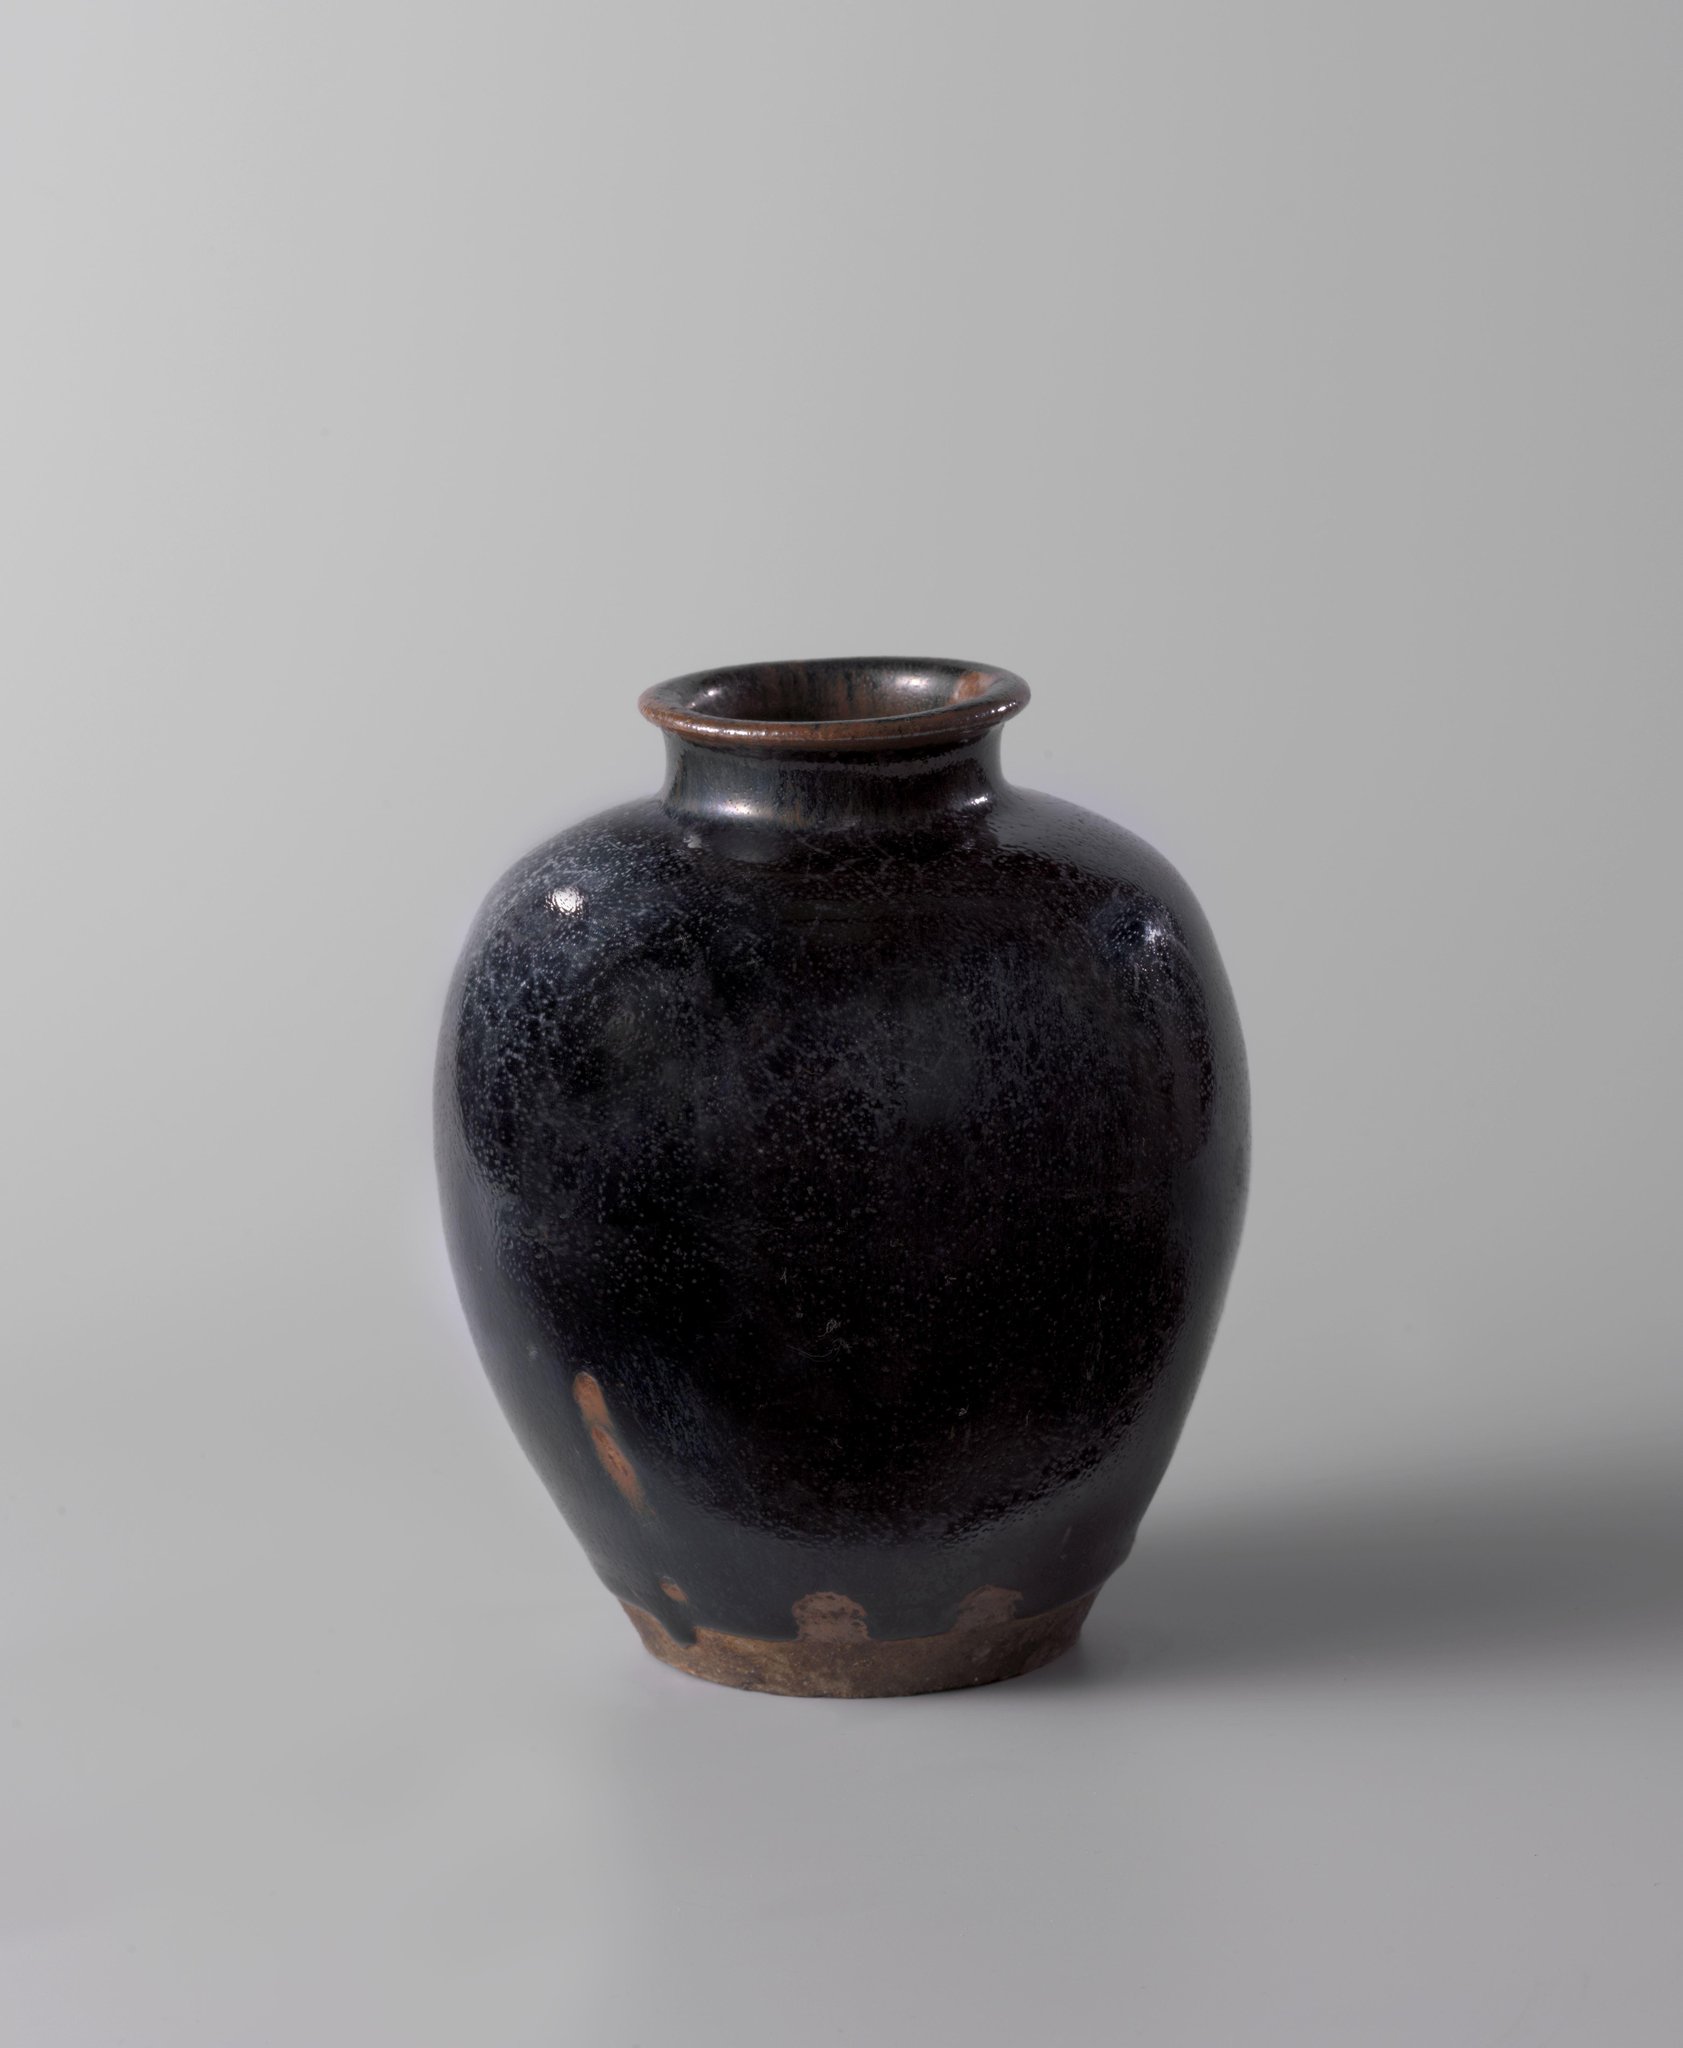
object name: vase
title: Ovoid vase with a black glaze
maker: Anonymous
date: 1000-1199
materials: glaze, stoneware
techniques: firing, turning, vitrification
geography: china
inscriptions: label: ‘W118’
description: Eivormige vaas van steengoed, gedeeltelijk bedekt met een zwart glazuur. De onderzijde is ongeglazuurd. In het glazuur bruin-gouden strepen. Oud label op de onderzijde met 'W118'. Cizhou.